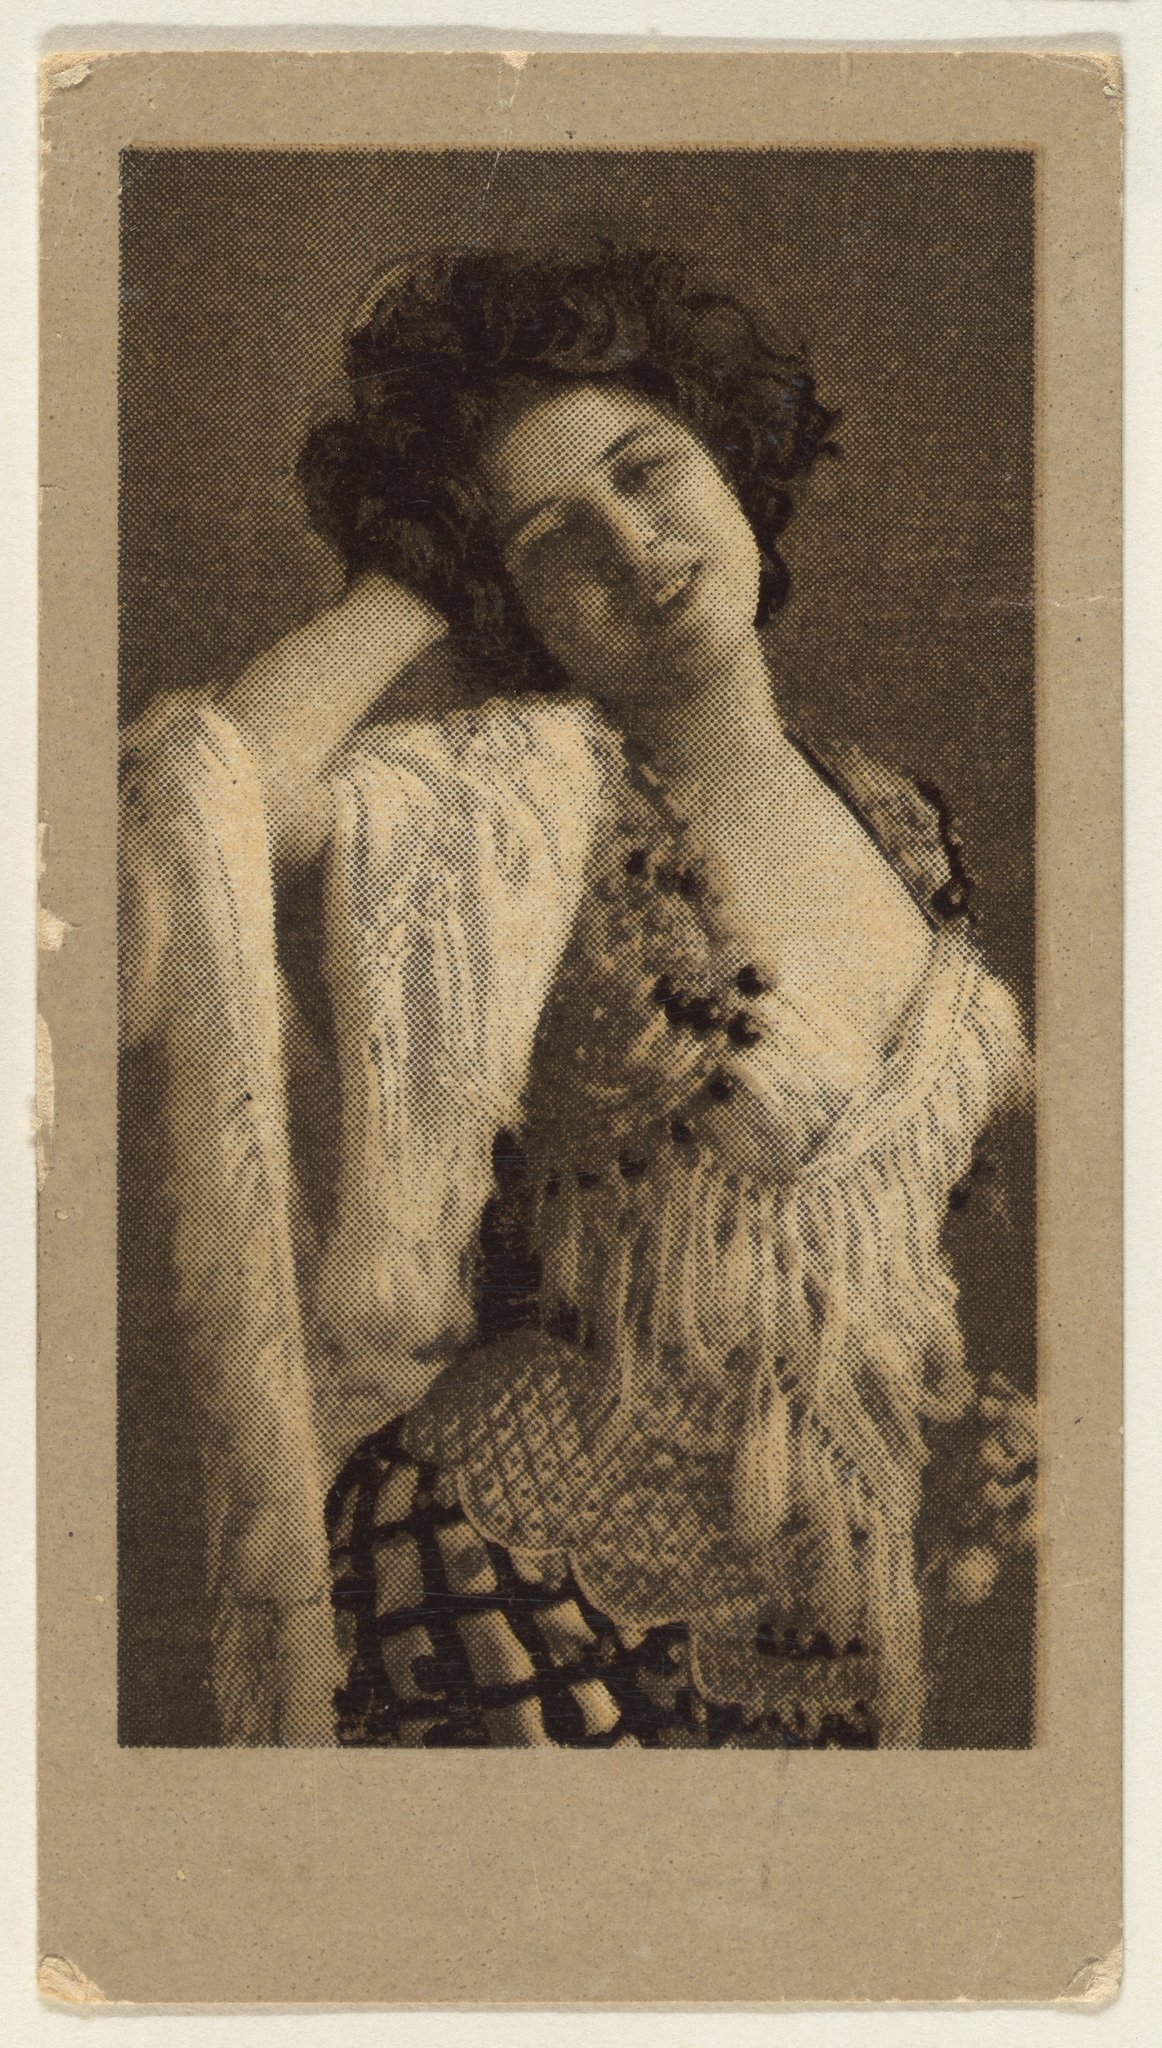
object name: print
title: Portrait of a woman, half-length, from the "Girls" series (T66), issued with Hunter Dog Cigarros by S. Monday & Sons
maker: s. monday & sons, brooklyn, new york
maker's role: publisher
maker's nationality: american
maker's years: 1850-1950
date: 1900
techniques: photolithograph